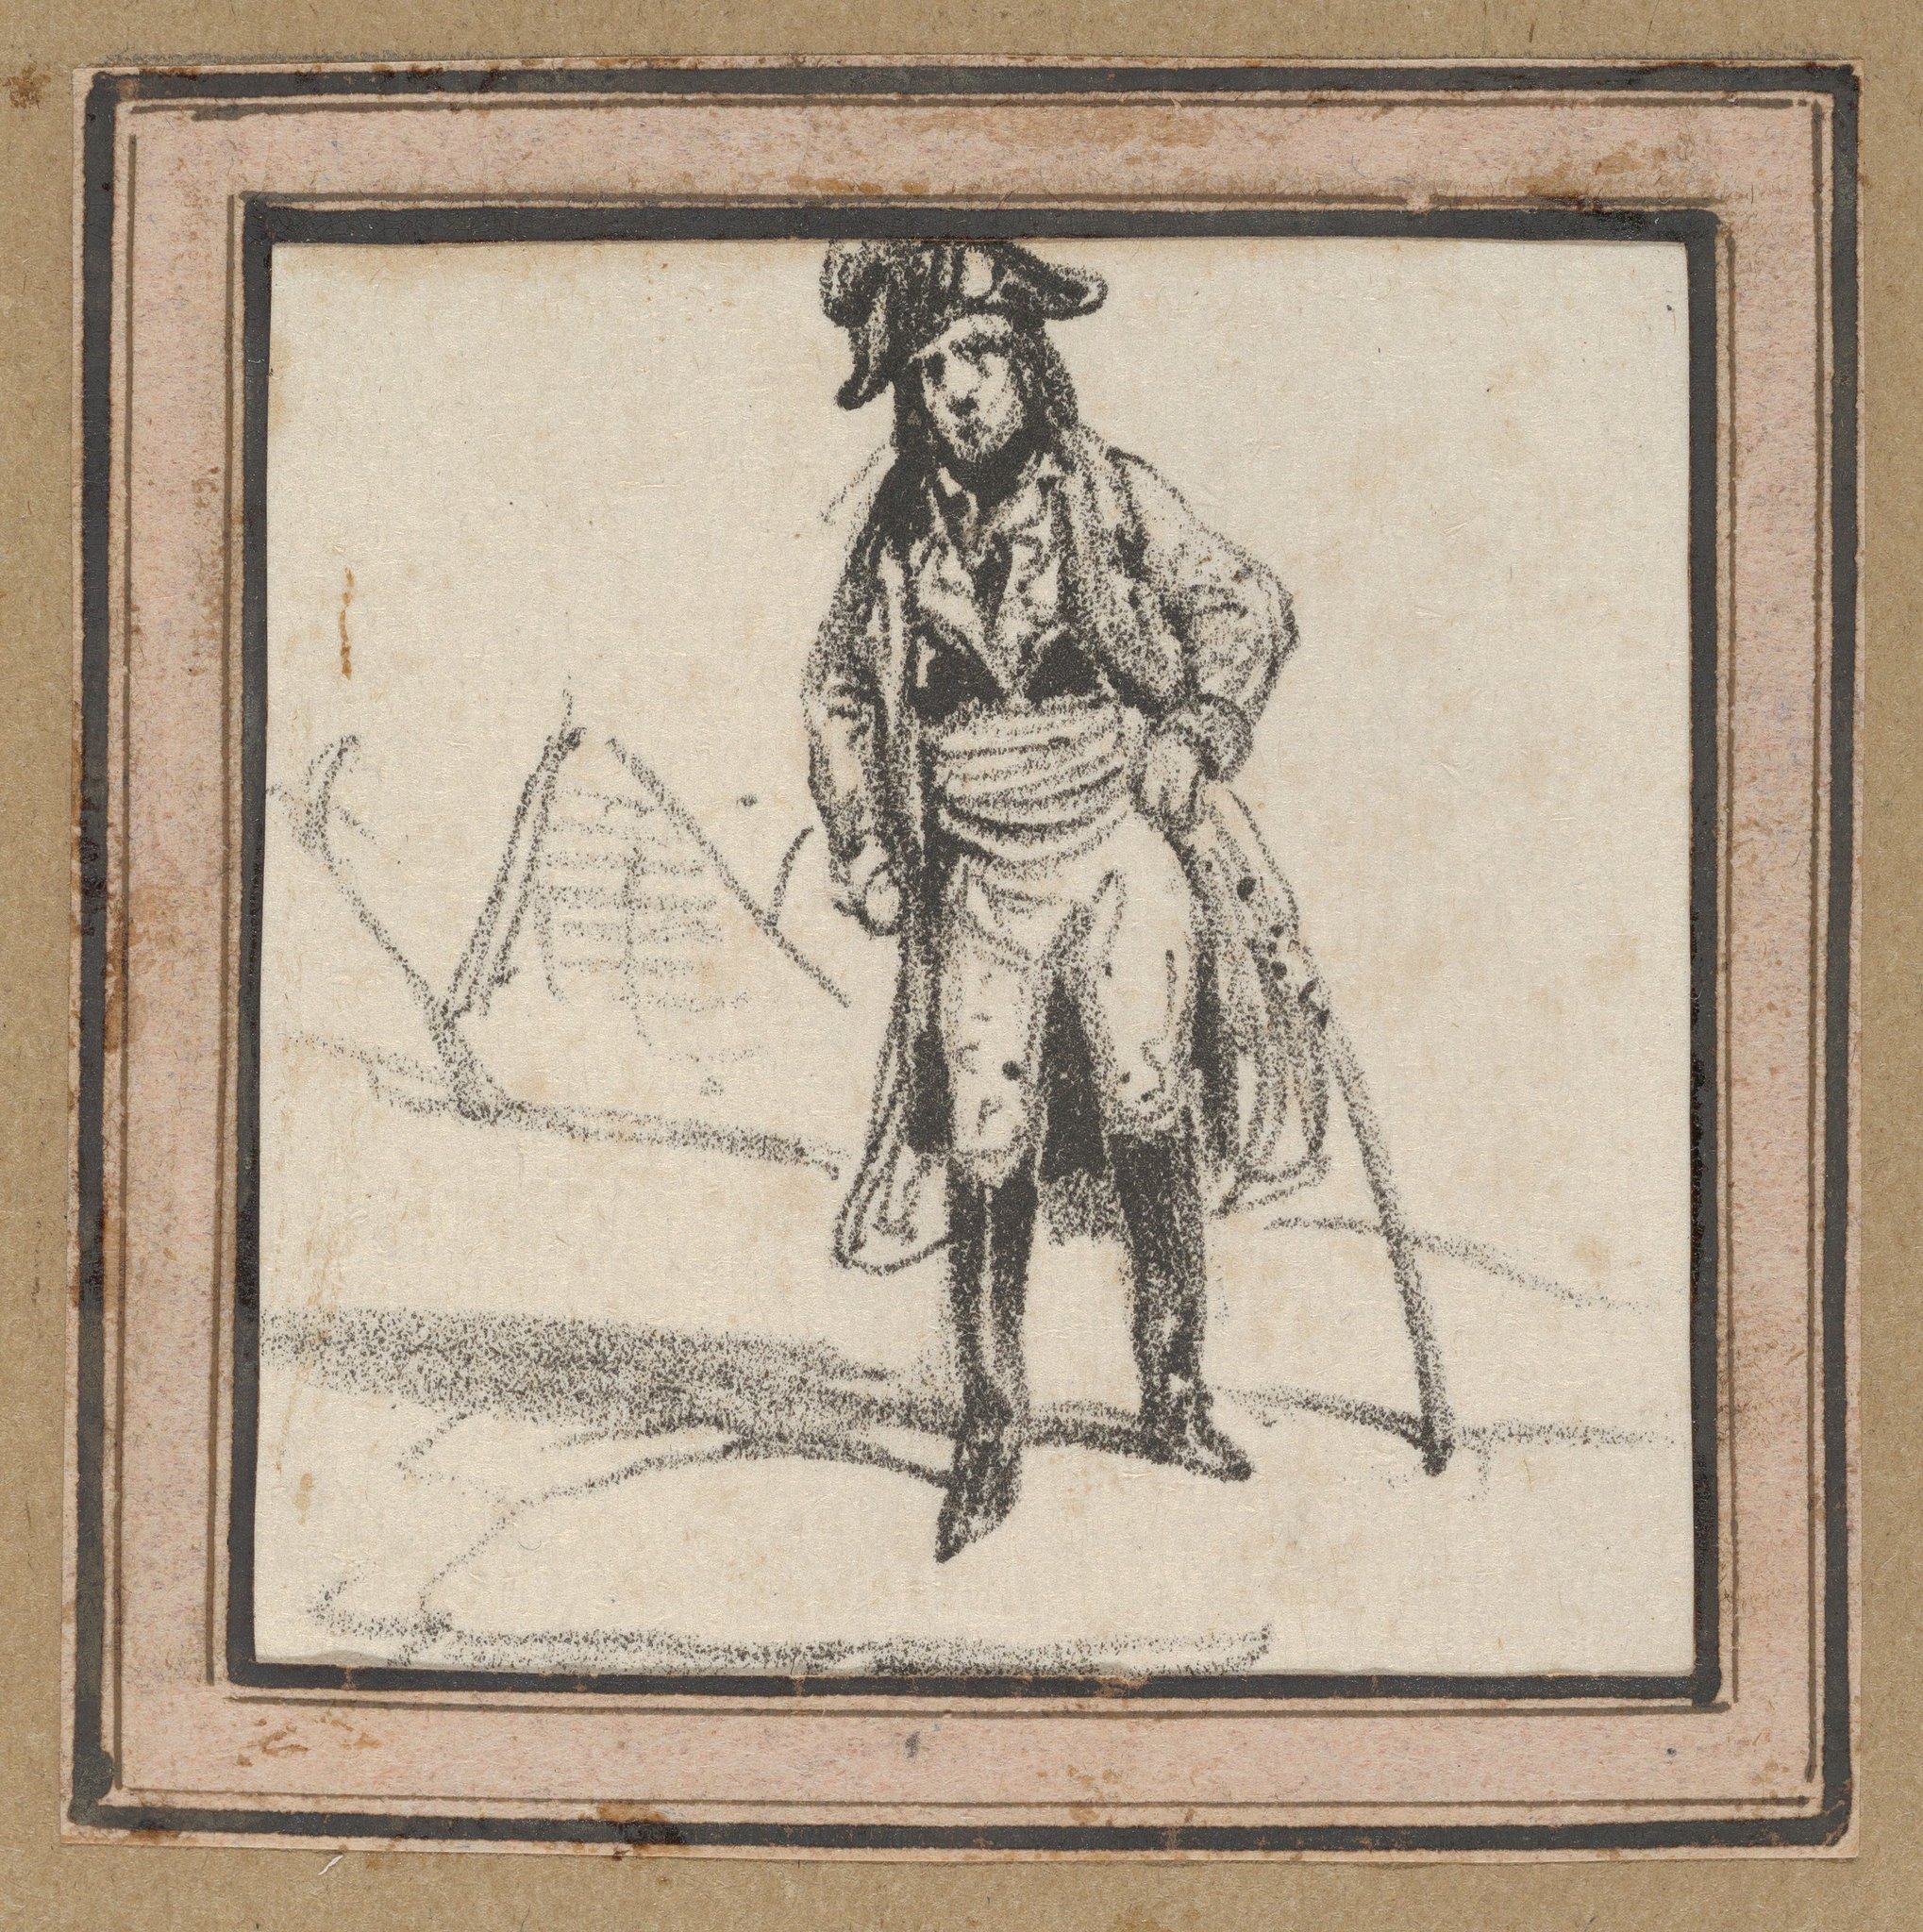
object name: print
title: Soldier leaning on his sword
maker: victor adam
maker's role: artist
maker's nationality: french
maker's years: 1801-1866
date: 1834-1866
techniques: lithograph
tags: soldiers,swords